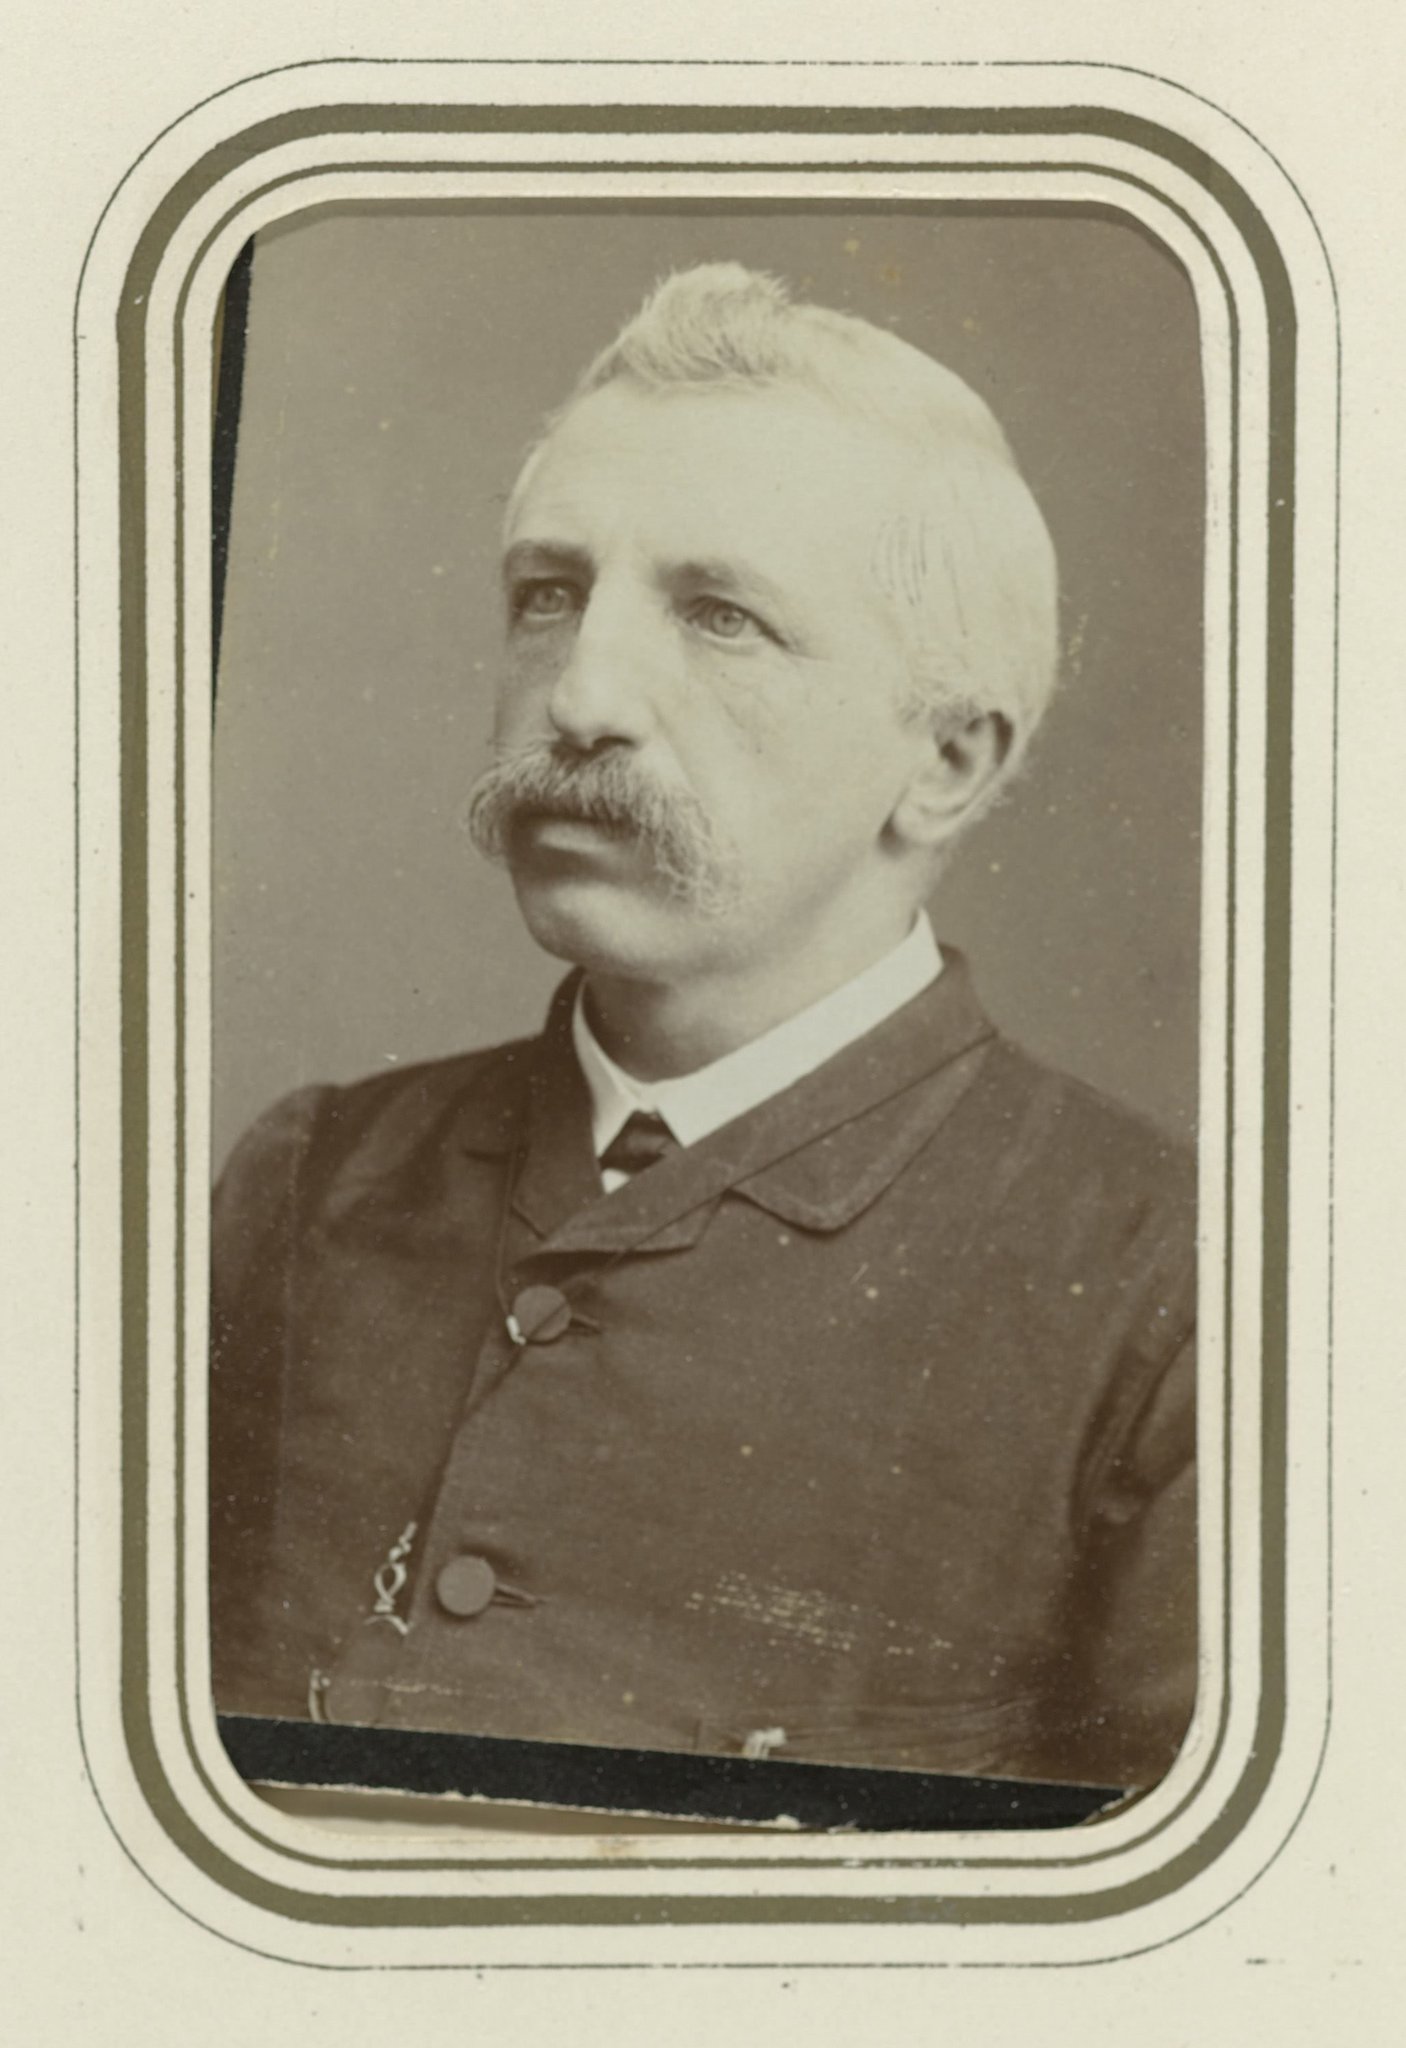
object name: photograph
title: Mansportret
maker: Anonymous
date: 1880-1886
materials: photographic support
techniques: photography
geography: dutch east indies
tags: the hague, anonymous historical person portrayed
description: Carte-de-visite met het portret van een onbekende man. Waarschijnlijk één van de aanbieders van het fotoalbum. Ingestoken in het fotoalbum aangeboden aan J.M. Pijnacker Hordijk bij zijn vertrek uit Jogyakarta in 1886.